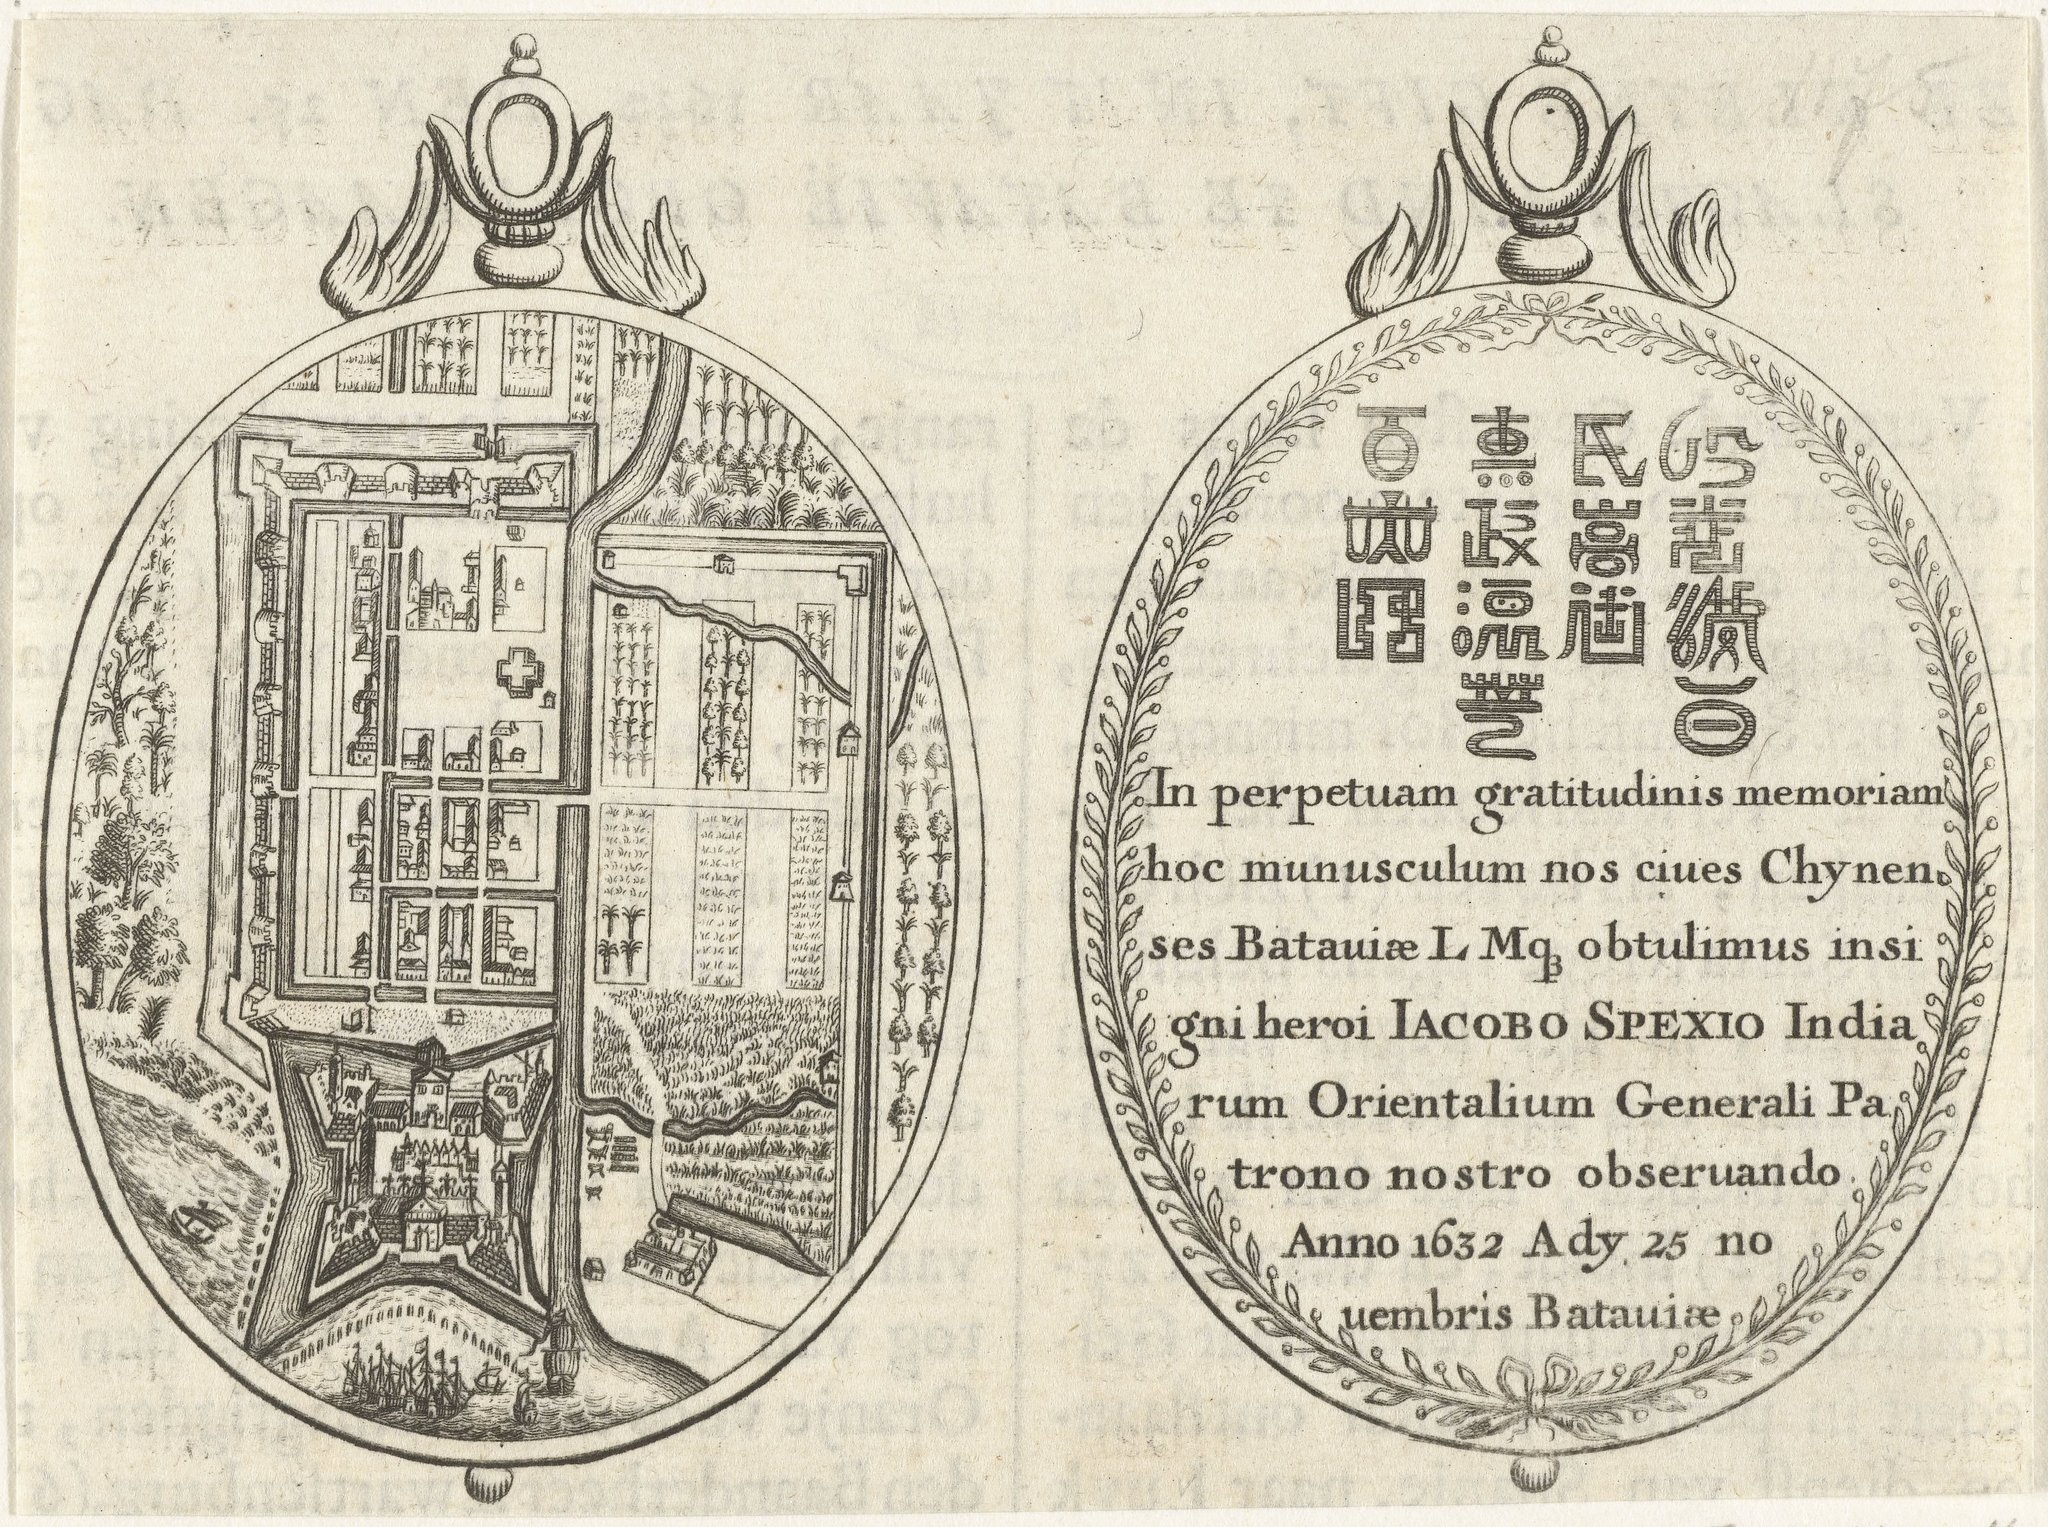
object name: historical object representation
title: Penning met plattegrond van Batavia, aangeboden aan Jacques Specx, 1632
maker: Anonymous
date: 1700-1799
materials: paper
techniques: etching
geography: netherlands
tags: decorations, honours (as symbols of the state, etc.), batavia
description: Penning met een plattegrond van Batavia en een inscriptie, opgedragen aan Jacques Specx, gouverneur-generaal van de VOC, 25 november 1632. Op achterzijde bedrukt met tekst in het Nederlands.